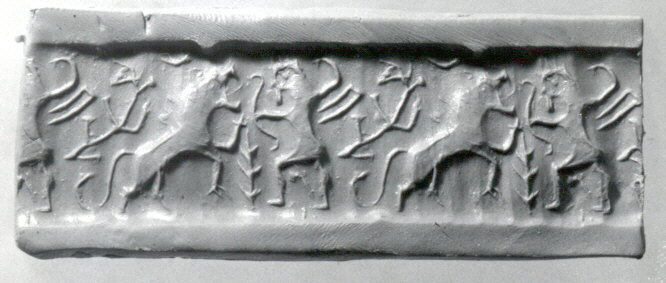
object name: cylinder seal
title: Cylinder seal with hunting scene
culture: assyrian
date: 900-701 BCE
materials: stone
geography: mesopotamia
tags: animals